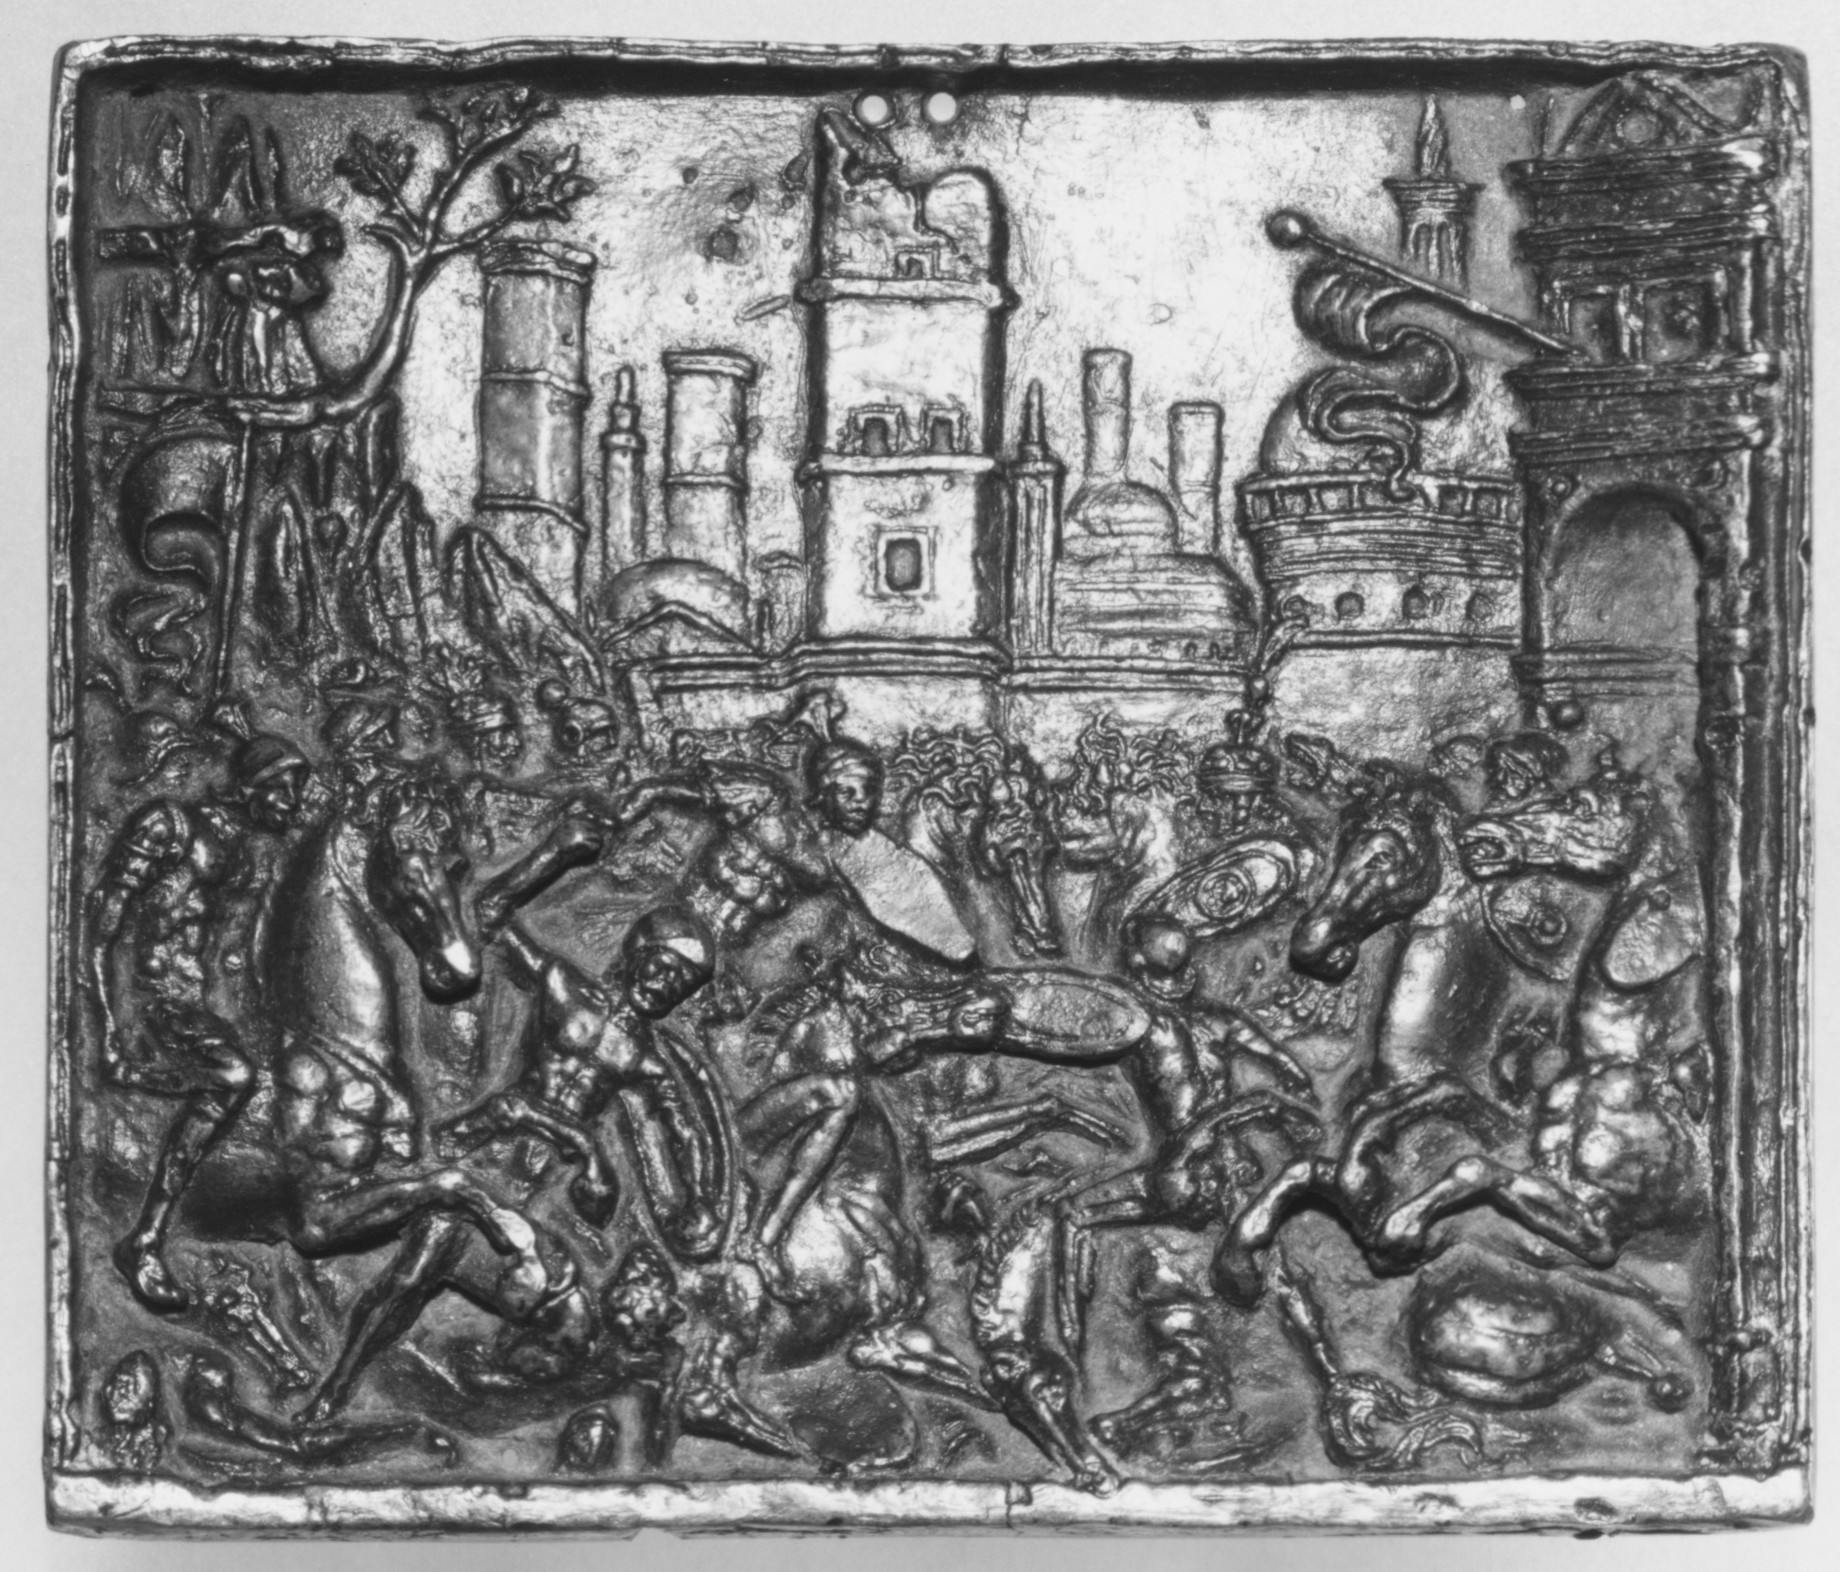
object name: plaquette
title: Combat at a City Gate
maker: andrea briosco, called riccio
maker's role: artist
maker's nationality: italian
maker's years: 1470-1532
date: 1501-1533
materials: bronze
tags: battles,soldiers,horses